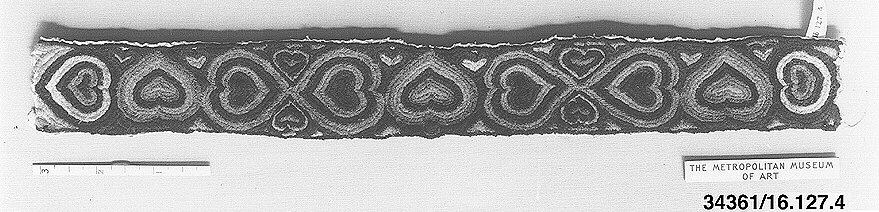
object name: strip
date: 1701-1900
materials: wool